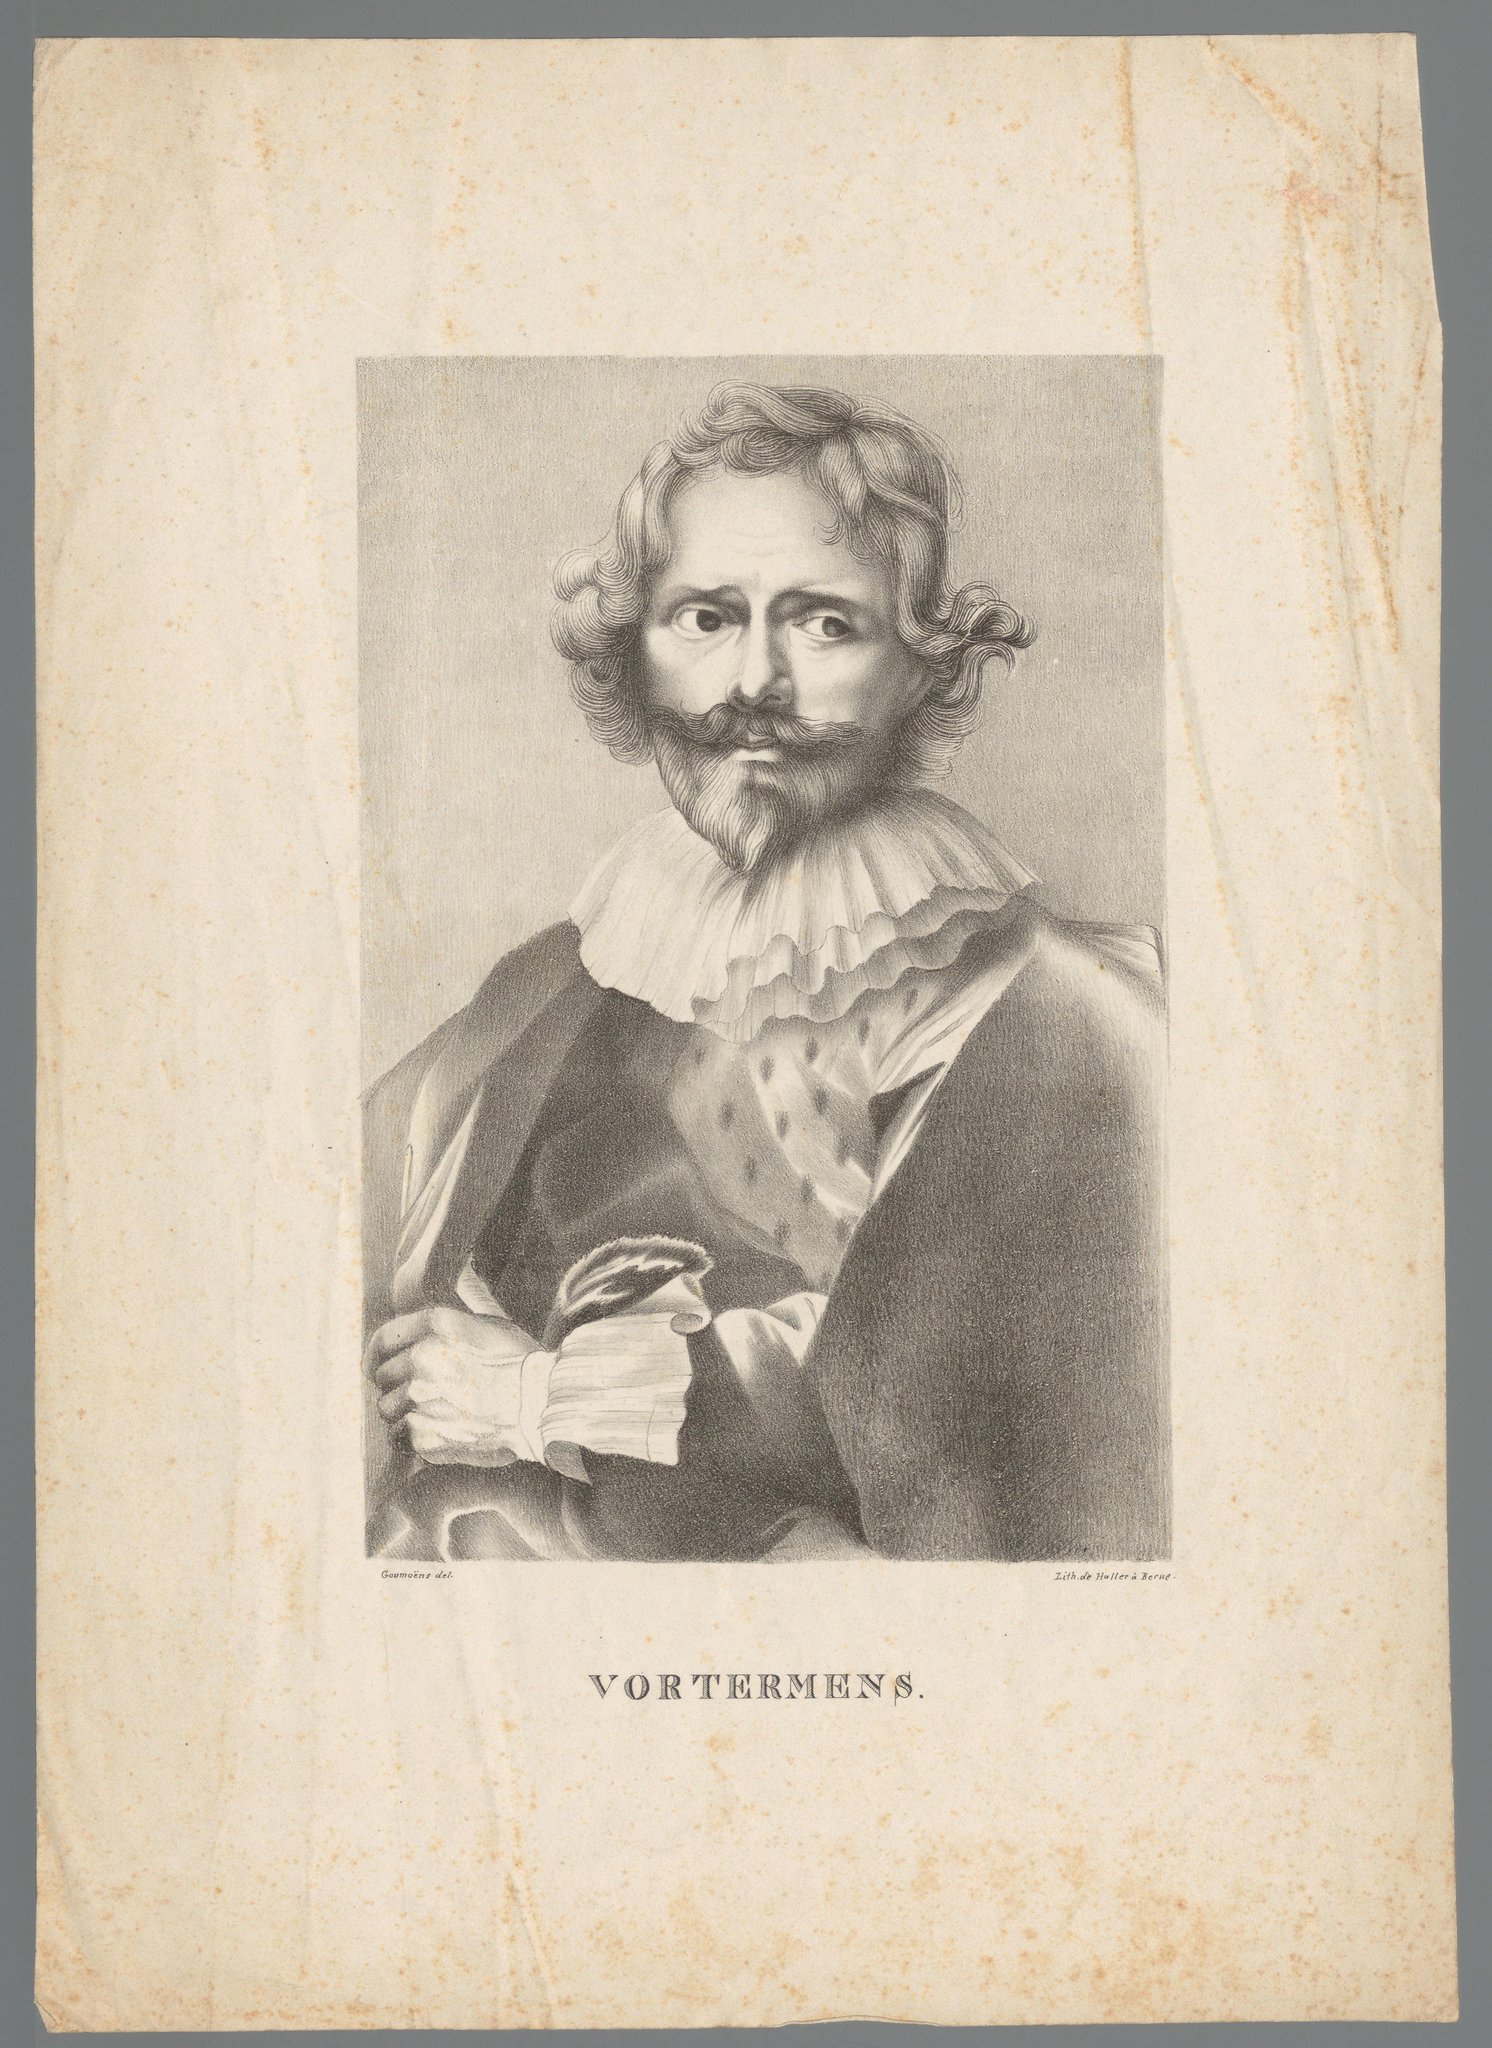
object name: print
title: Portret van Lucas Vorsterman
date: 1820-1850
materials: paper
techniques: lithograph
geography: bern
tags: antwerp, print maker, lucas vorsterman (i), adult man, historical persons, beard